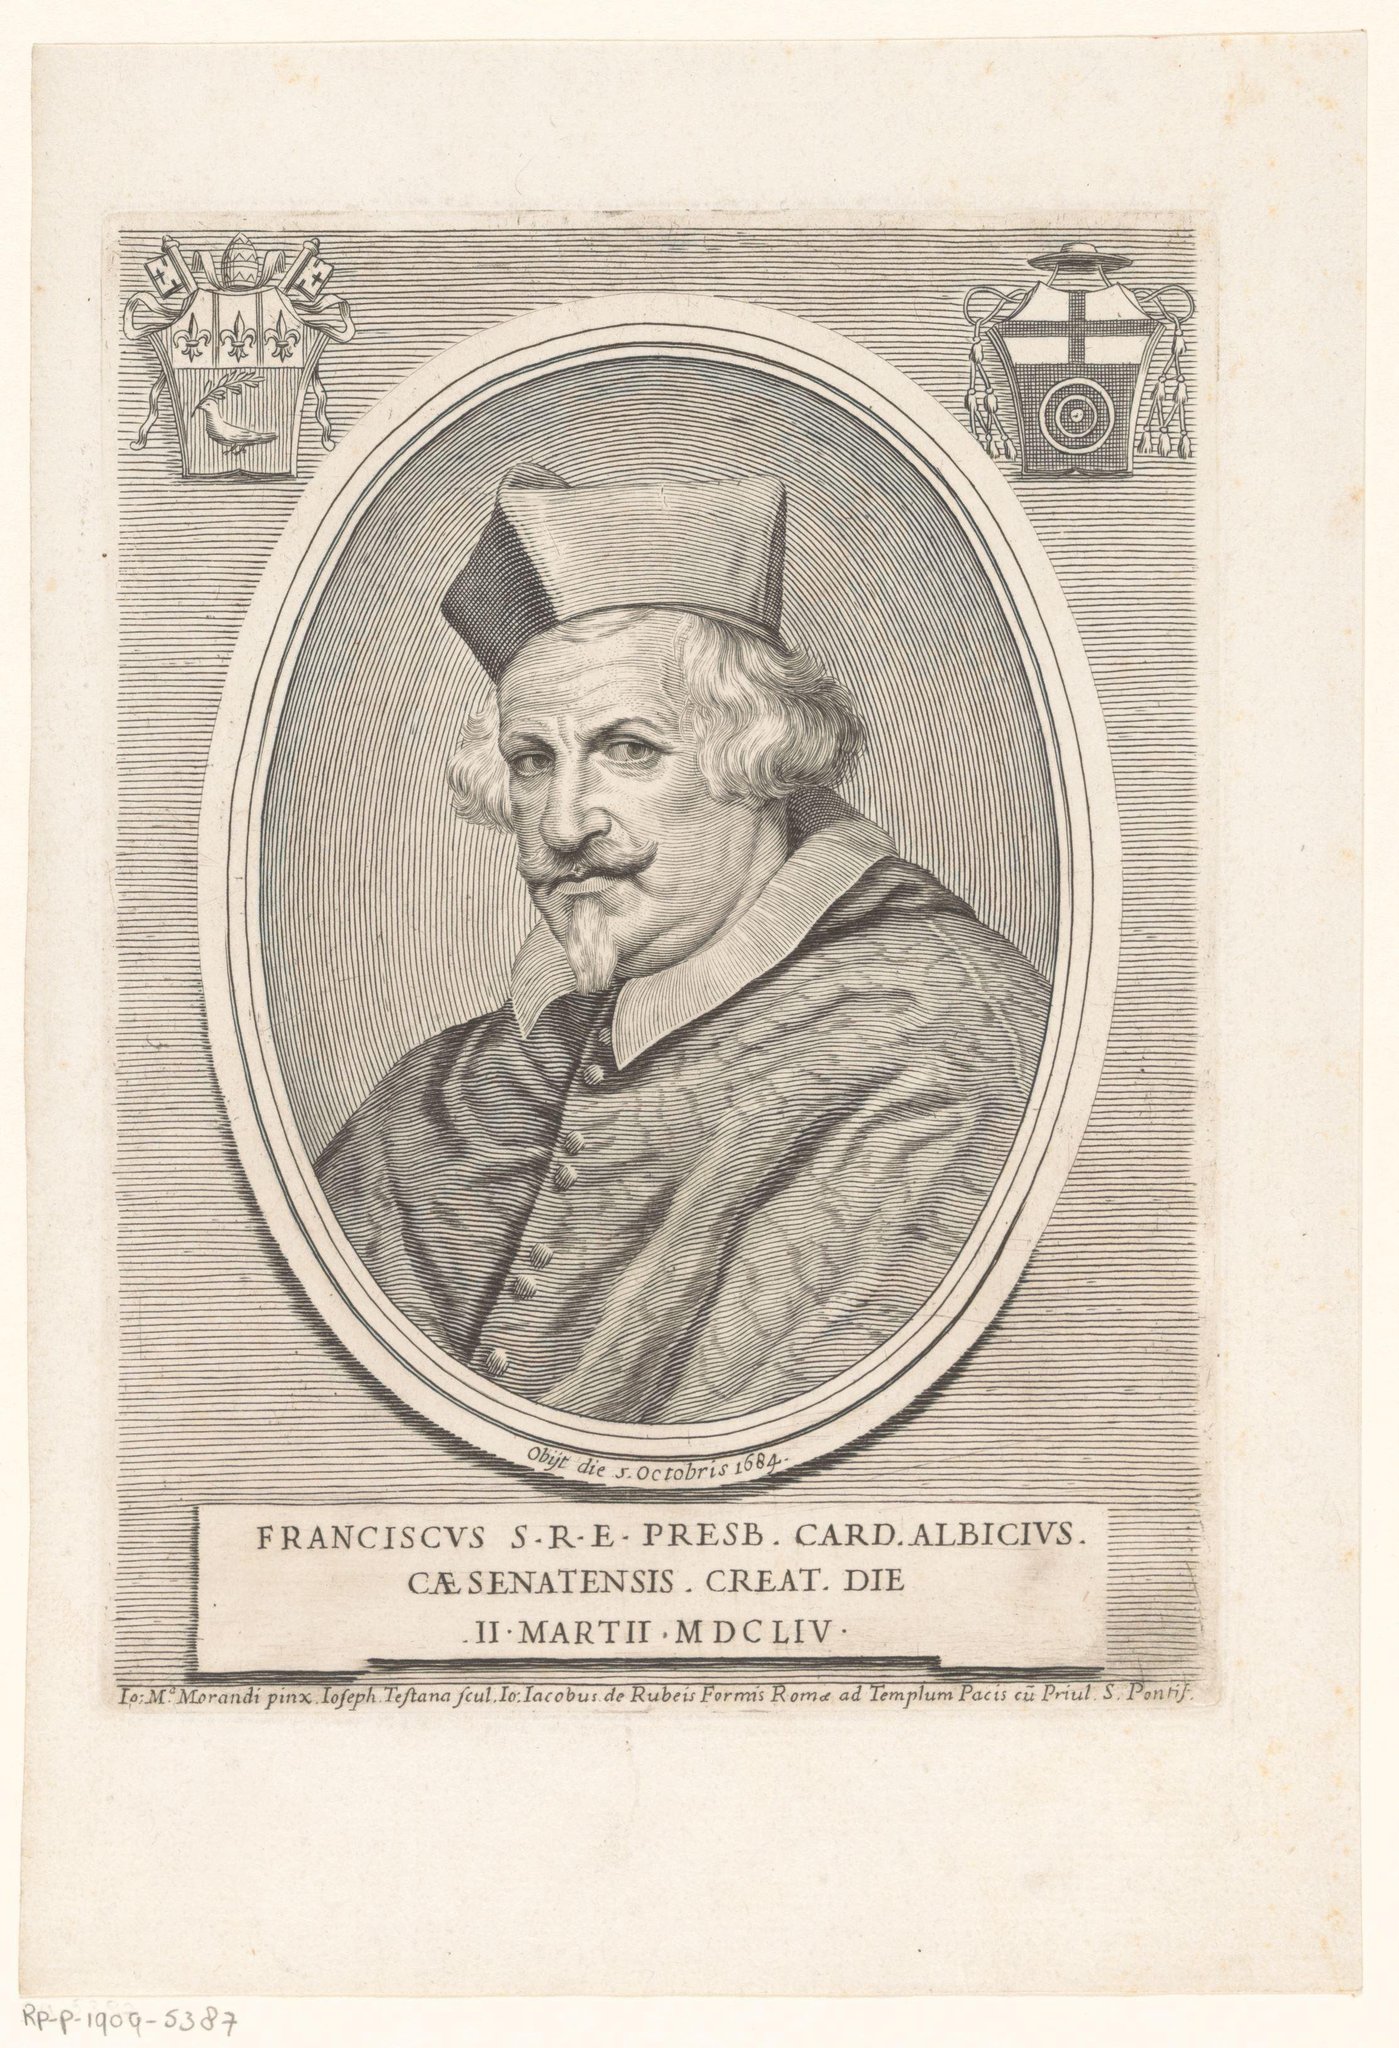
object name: print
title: Portret van kardinaal Francesco Albizzi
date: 1658-1679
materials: paper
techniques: engraving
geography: rome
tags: rome, cardinal, historical persons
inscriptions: collector's mark: Lugt 2228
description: Prent uit een reeks van onbekende omvang met portretten van kardinalen. De prenten werden vanaf 1657 vervaardigd in opdracht van uitgever Giovanni Giacomo de’ Rossi, waarna de productie werd voortgezet onder leiding van zijn opvolgers Domenico de’ Rossi en Lorenzo Filippo de’ Rossi, en ten slotte onder leiding van de Calcographia R.C.A.